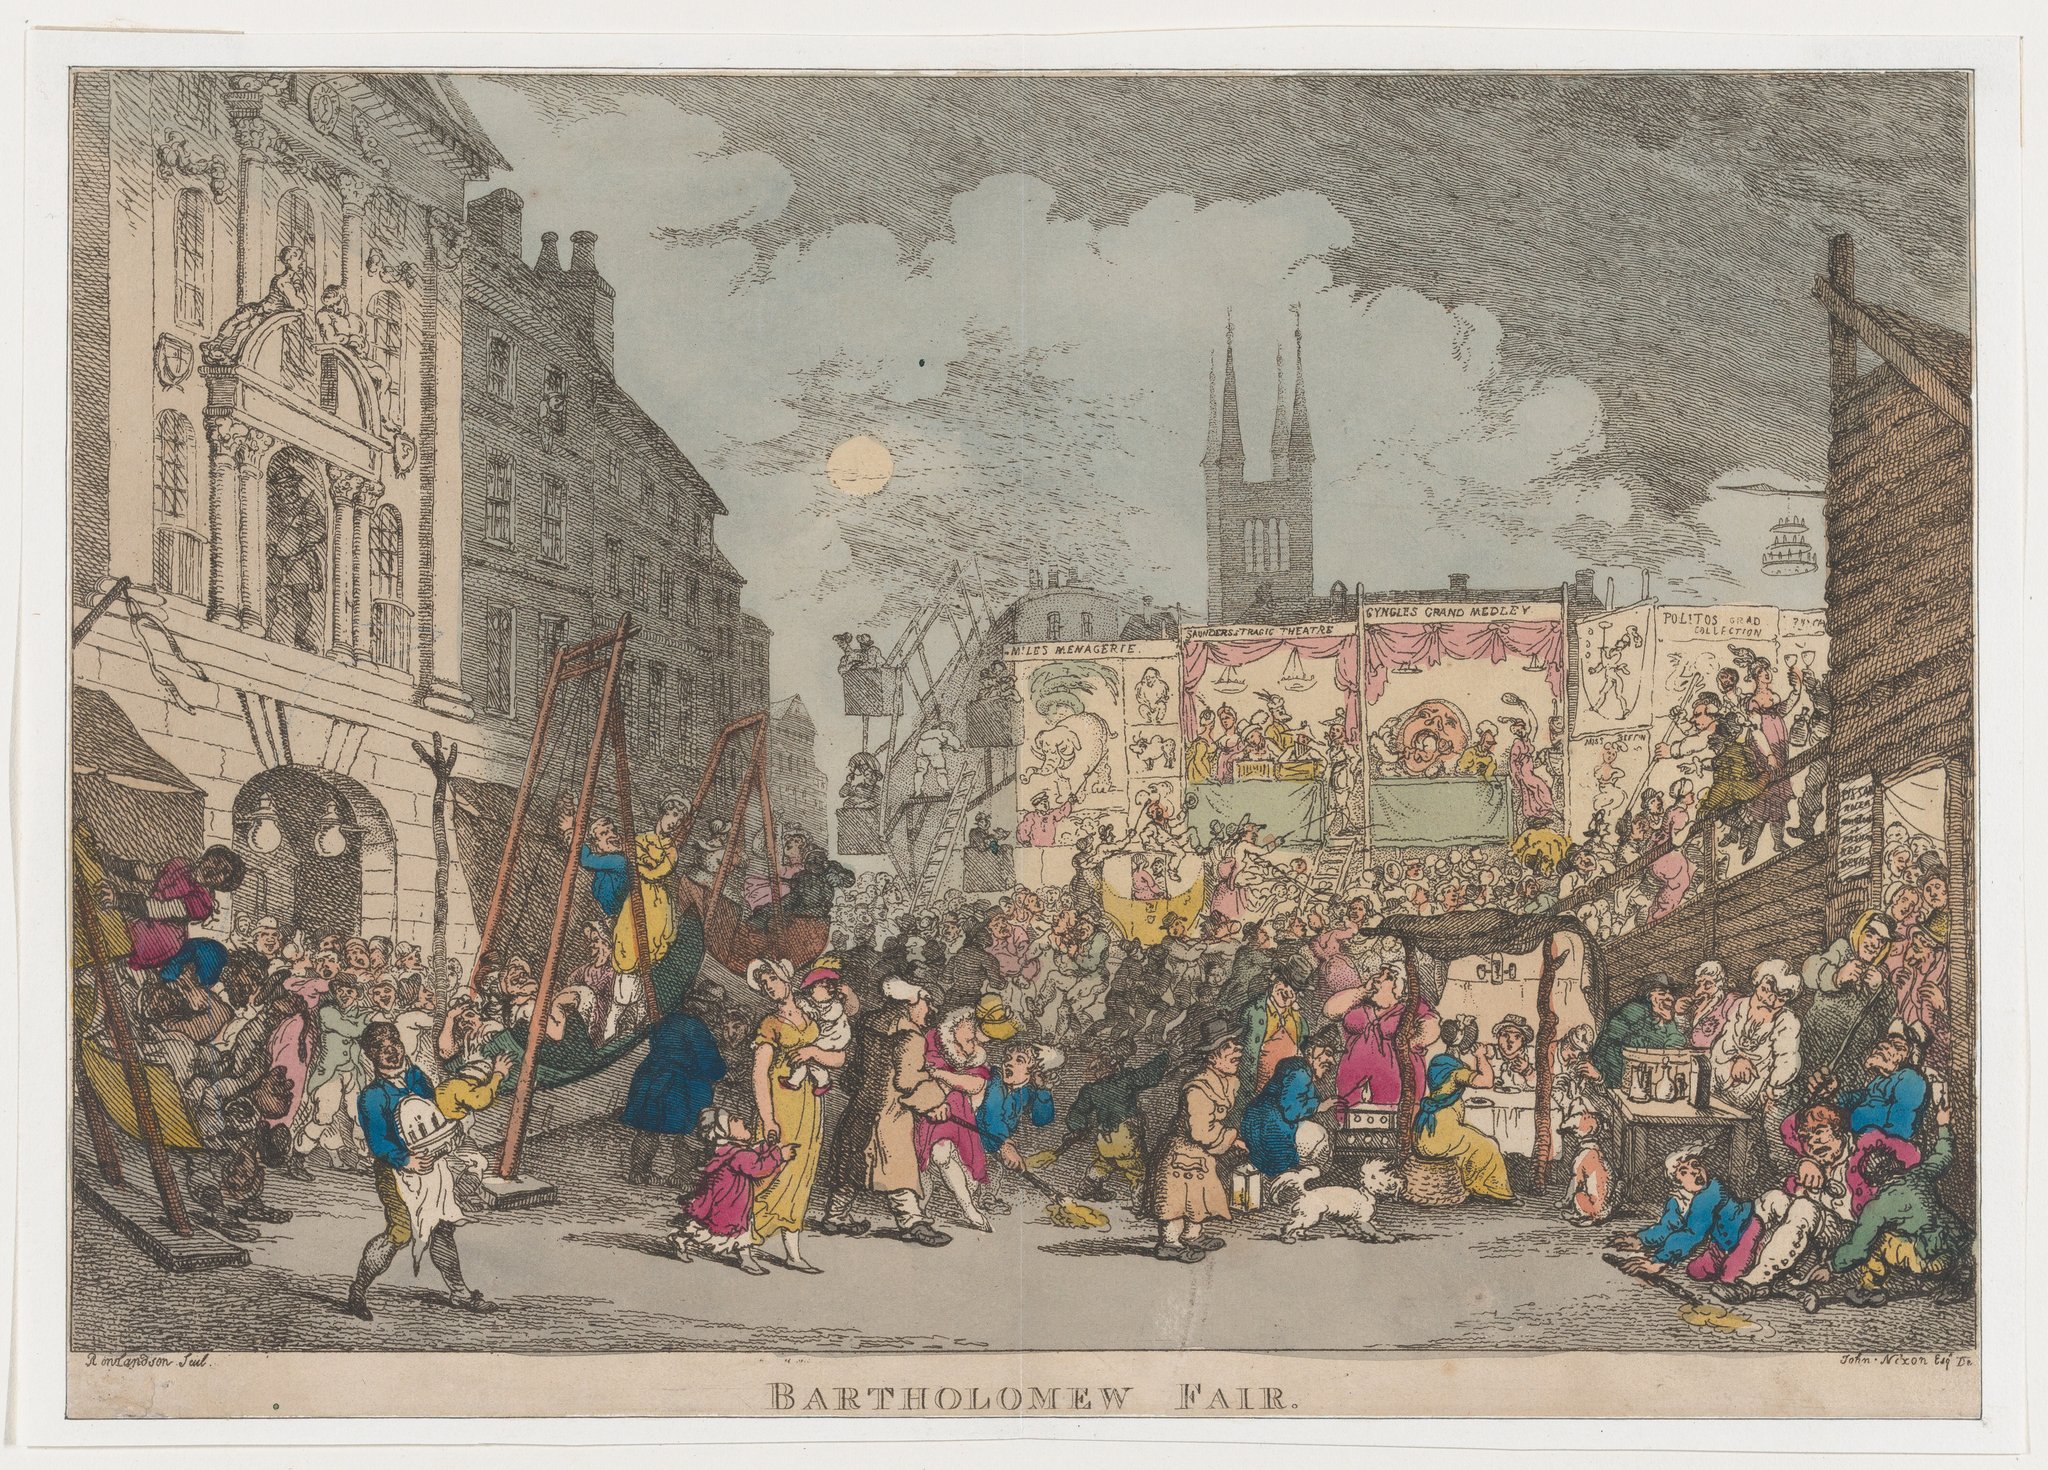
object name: print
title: Bartholomew Fair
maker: thomas rowlandson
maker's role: artist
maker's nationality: british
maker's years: 1757-1827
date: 1807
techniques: etching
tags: satire,dogs,crowd